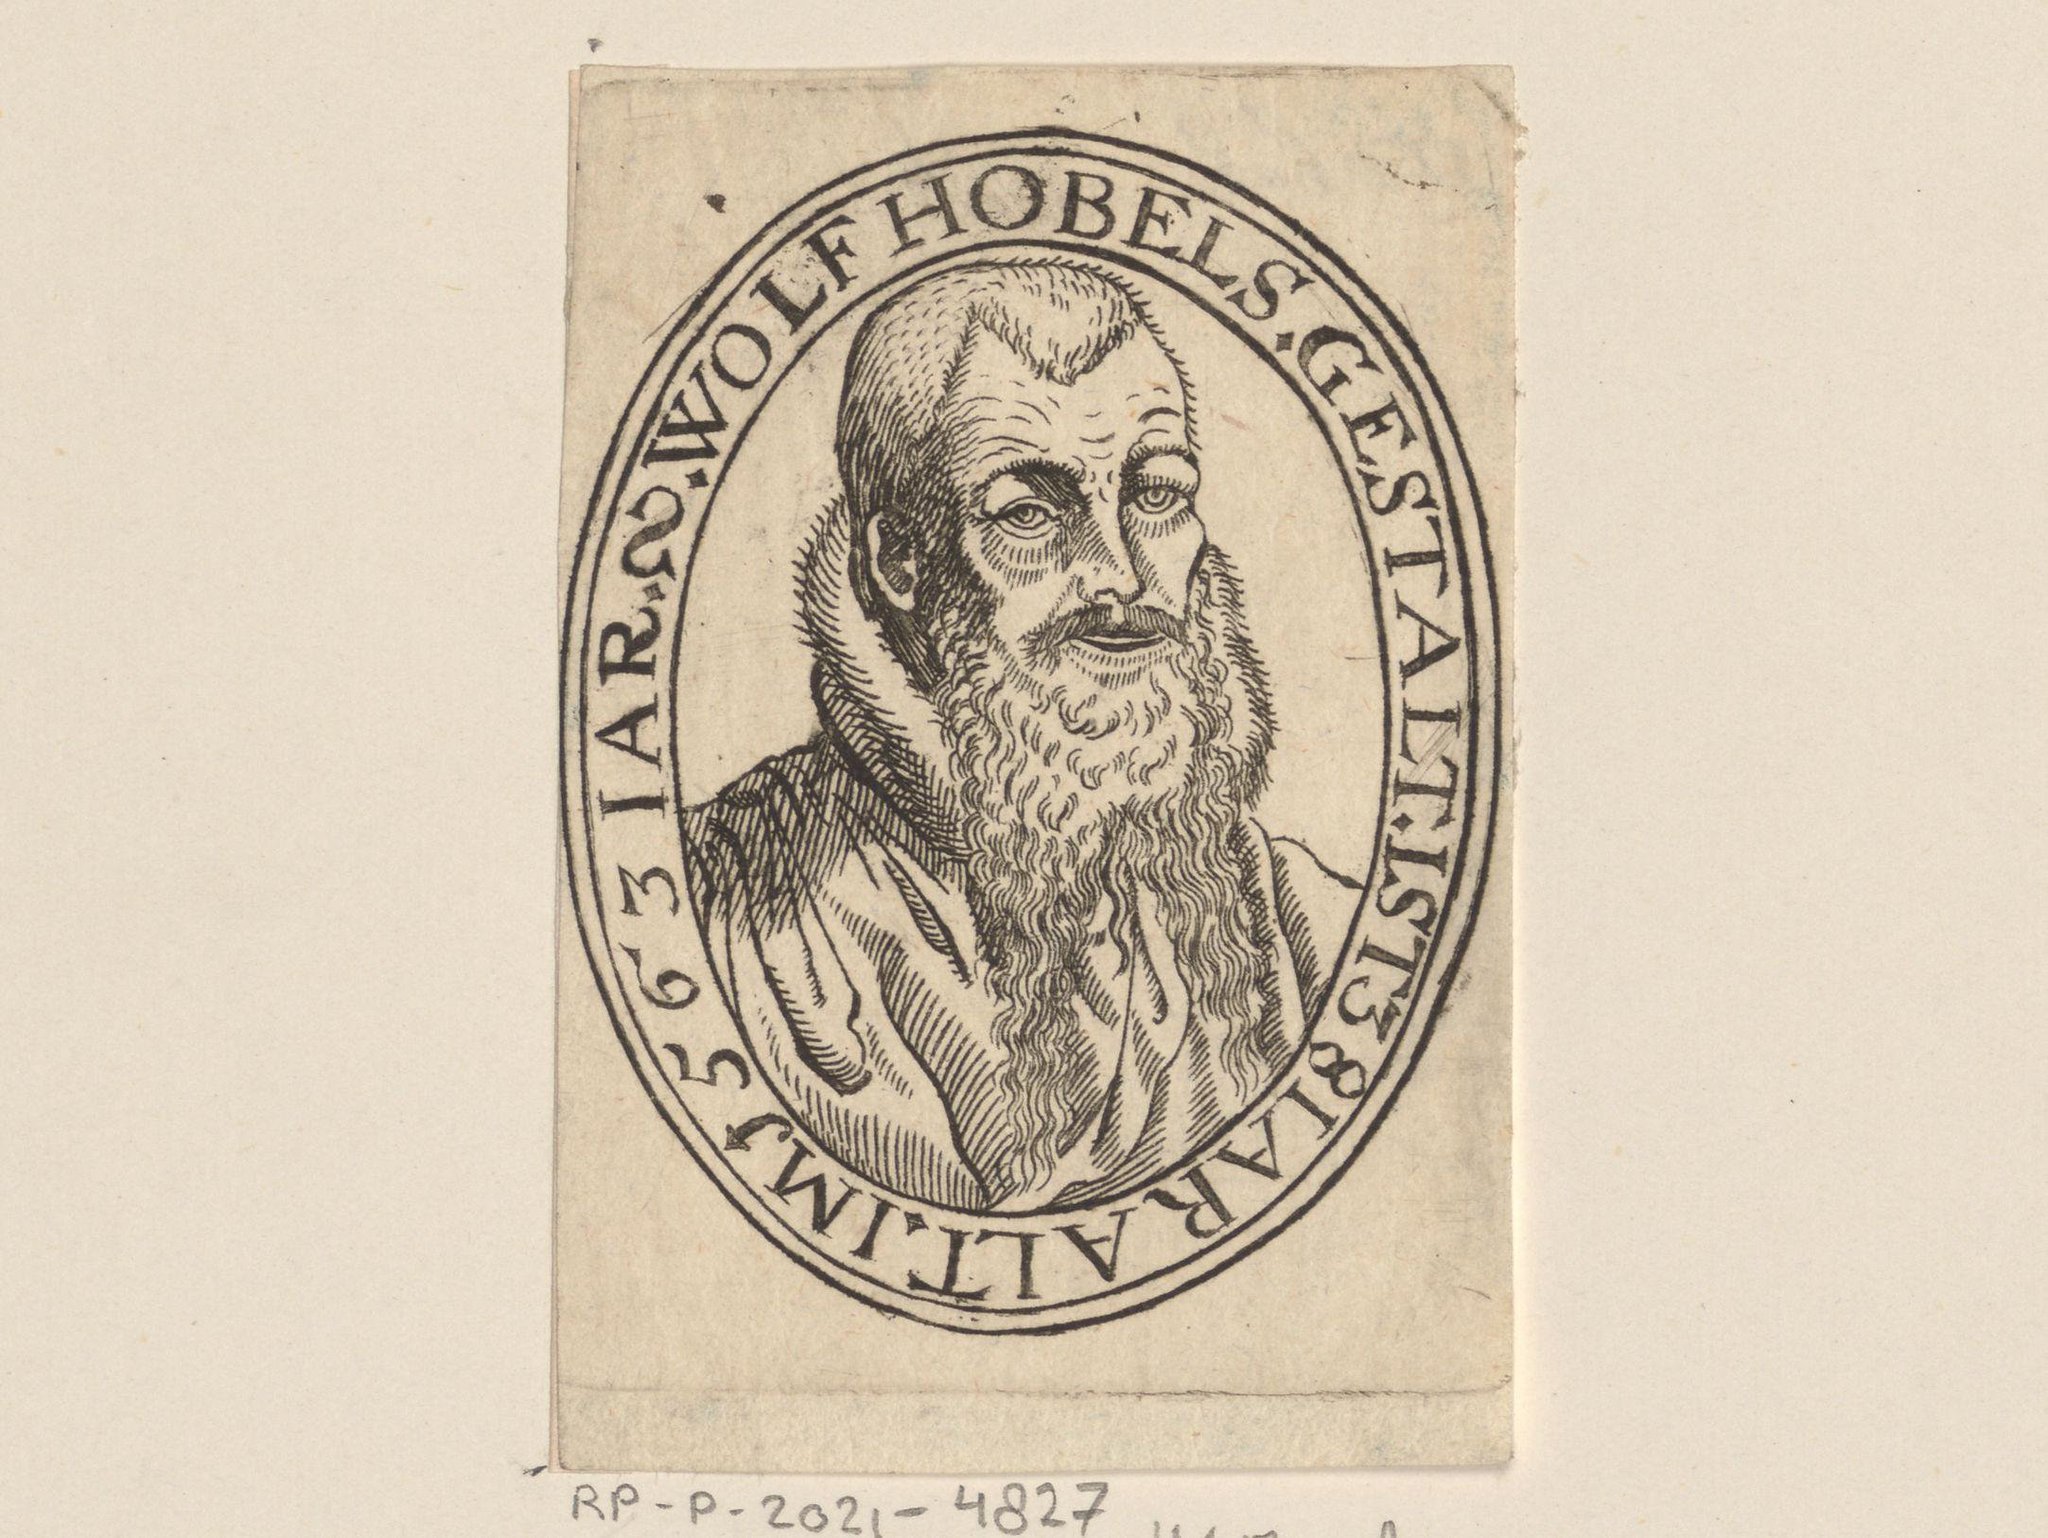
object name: print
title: Portret van Wolf Hobel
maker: Anonymous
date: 1600-1699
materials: paper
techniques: engraving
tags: historical persons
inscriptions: inscription: ‘Hobel 1234’